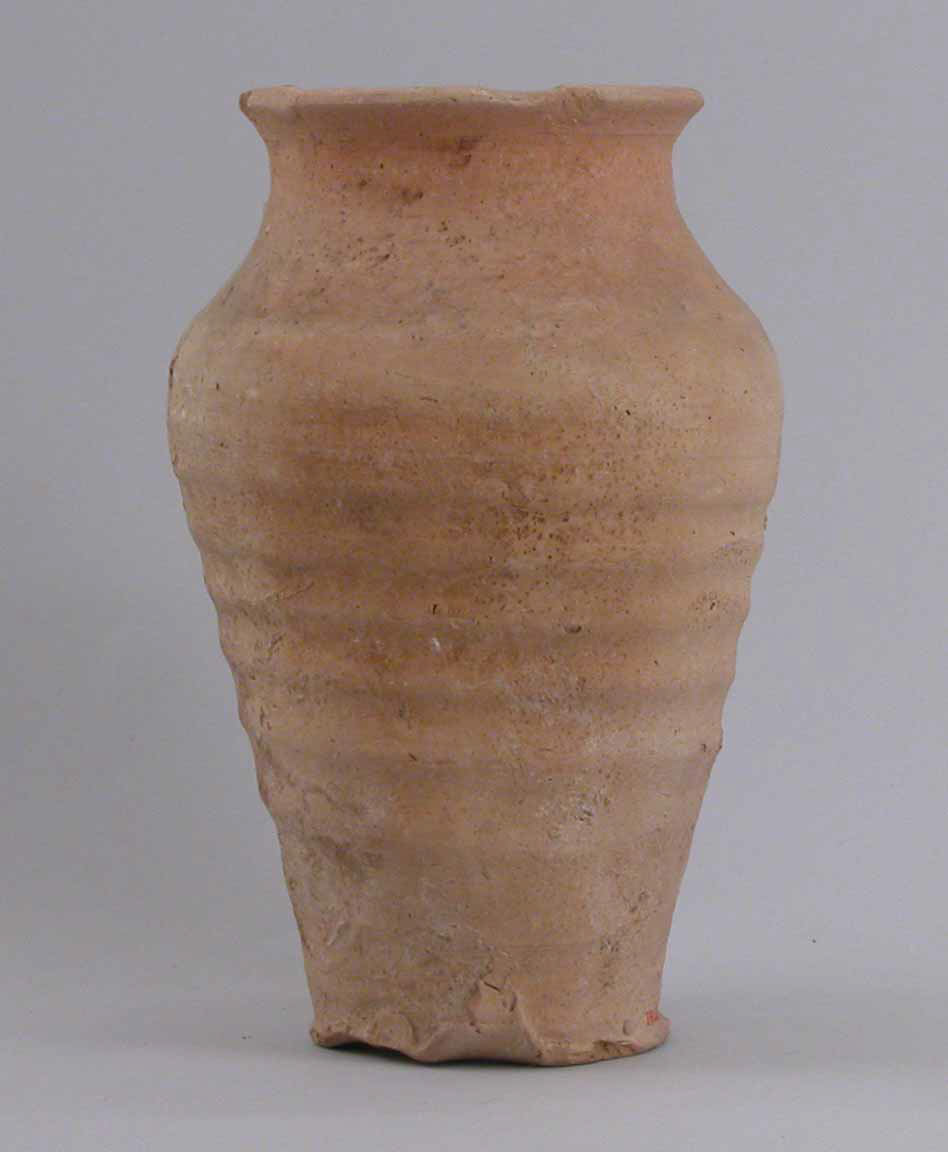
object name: jar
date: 801-1000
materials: earthenware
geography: iran